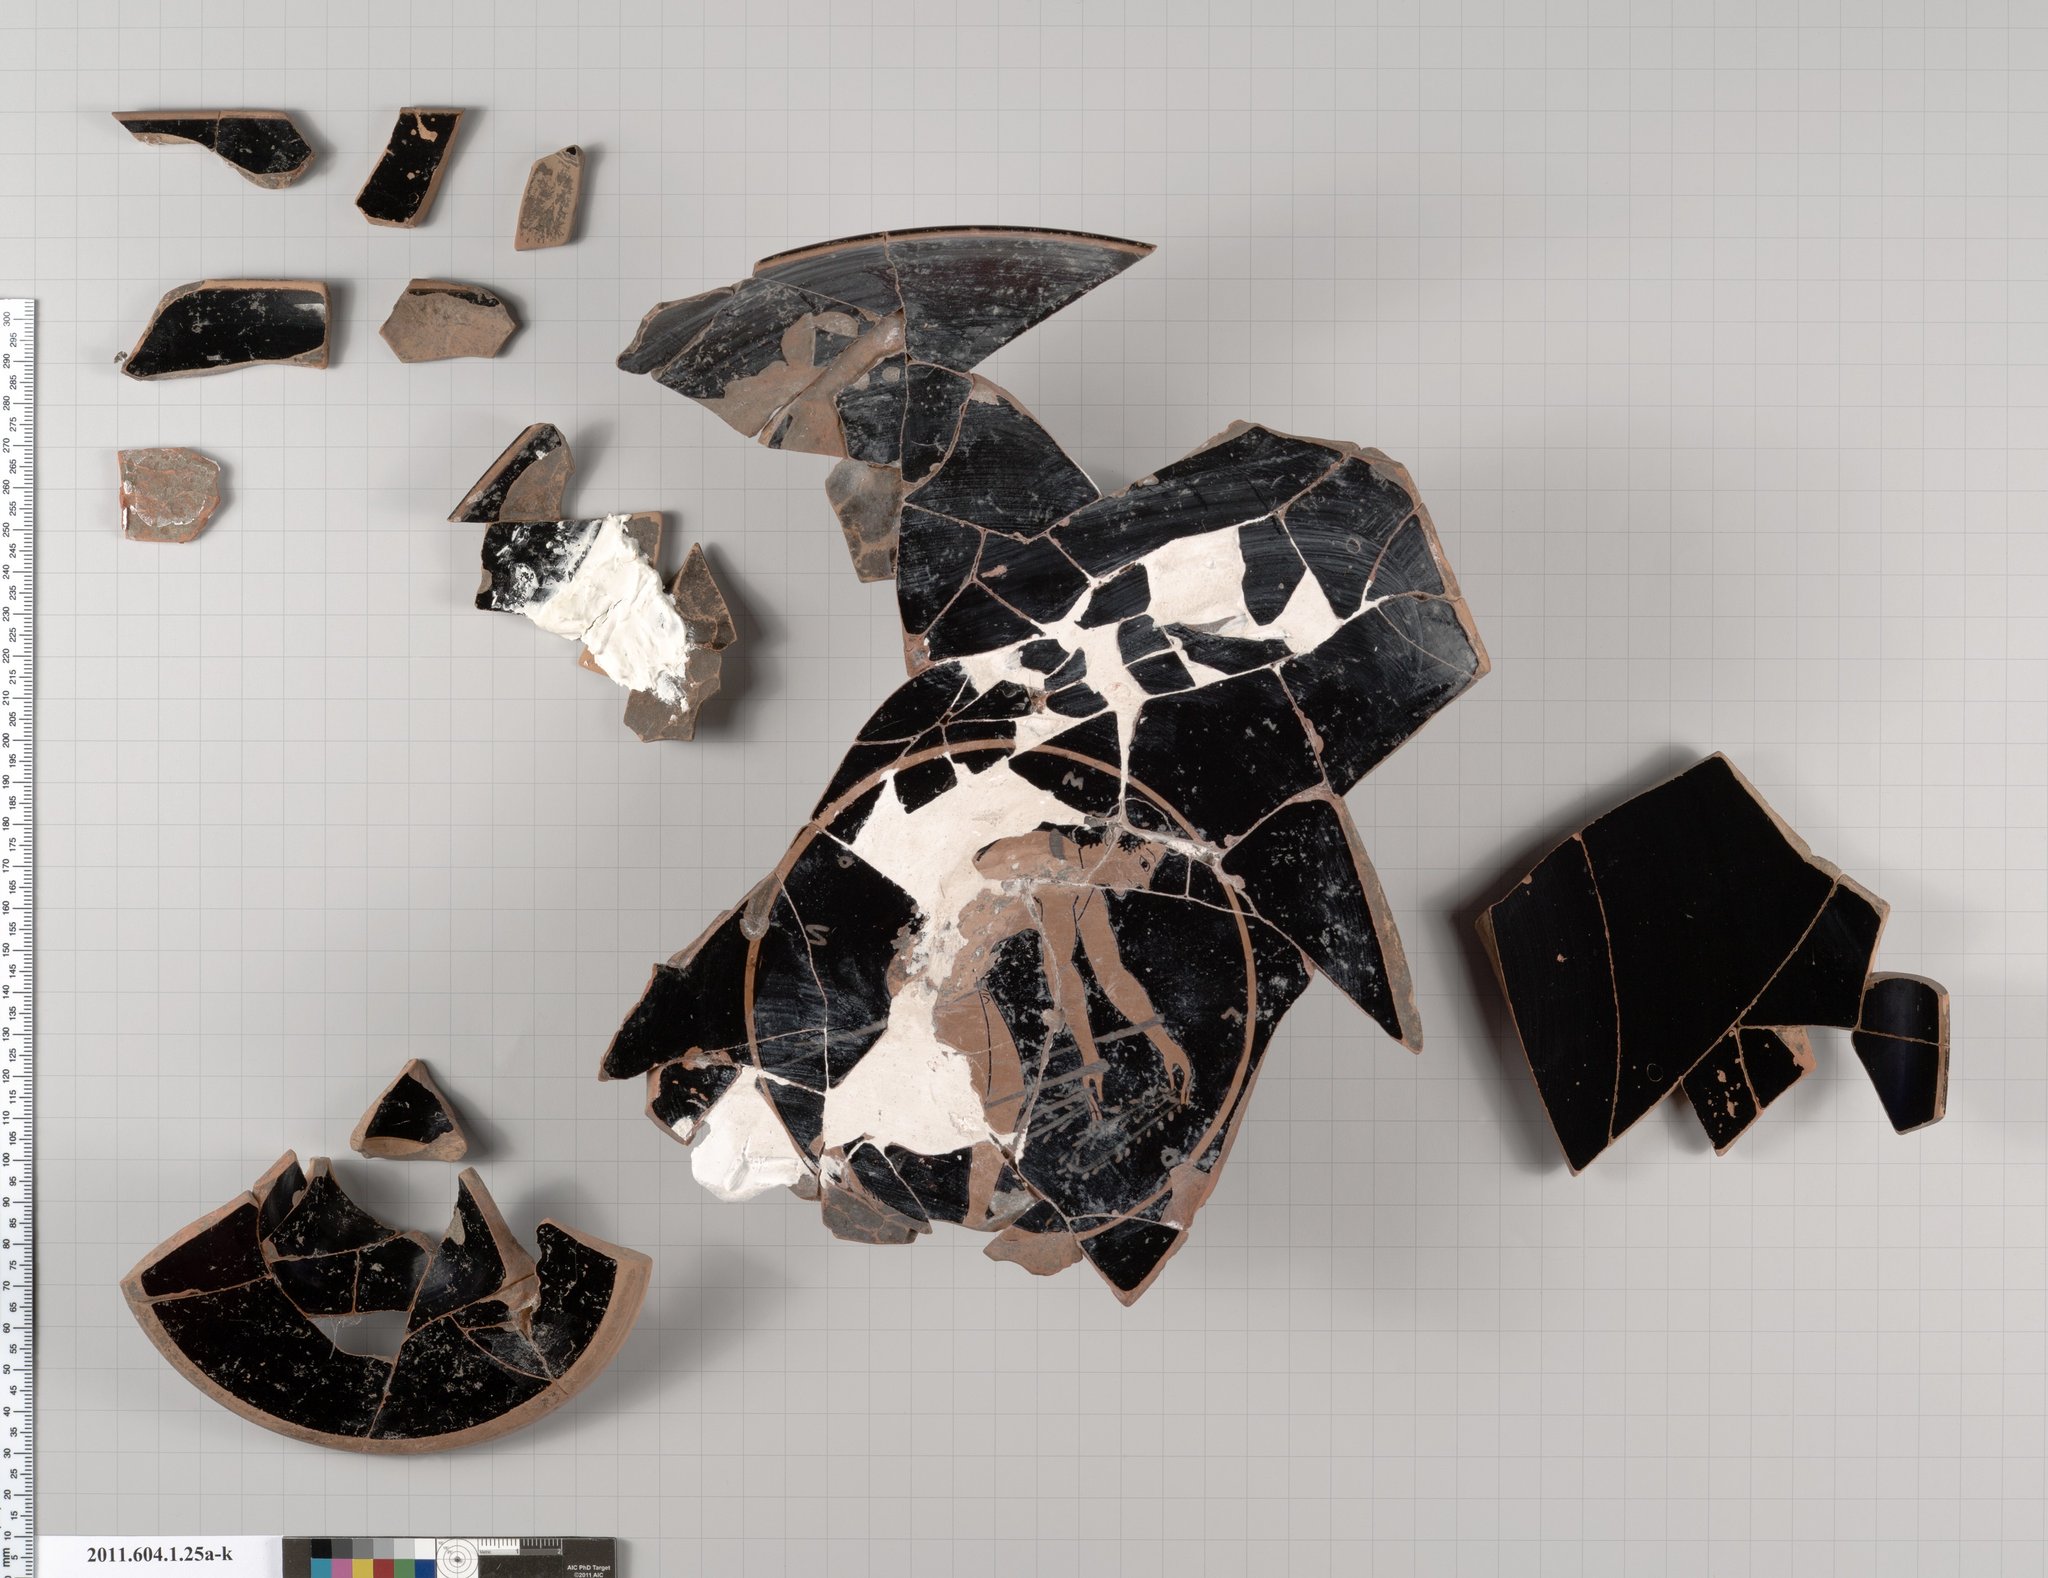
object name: kylix fragment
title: Terracotta fragments of a kylix (drinking cup)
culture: greek, attic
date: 510-500 BCE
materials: terracotta